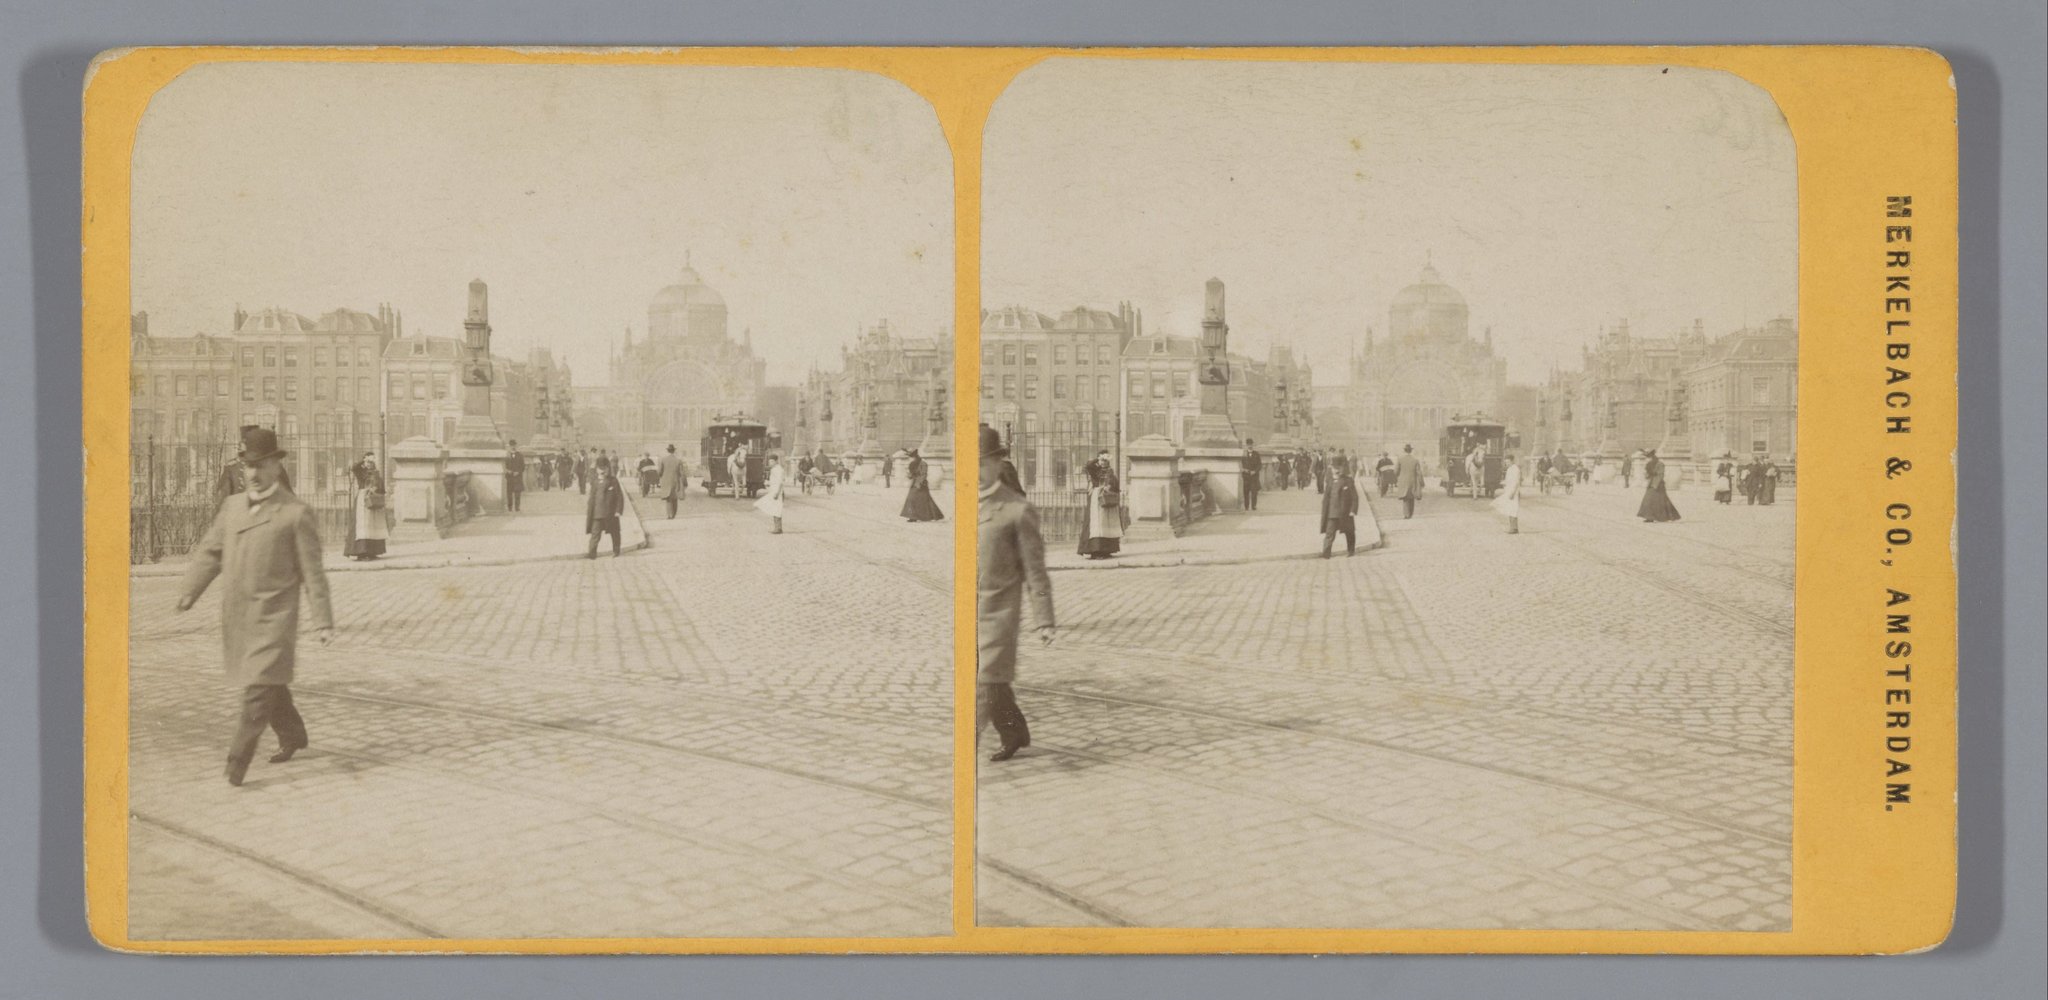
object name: stereograph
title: Hogesluis en het Paleis voor Volksvlijt, Amsterdam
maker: Anonymous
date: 1883-1910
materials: cardboard, paper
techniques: albumen print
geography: amsterdam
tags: bridge in city across river, canal, etc., edifice, e.g.: public building, department store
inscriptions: inscription: ‘61. Hoogesluis te/ Amsterdam’